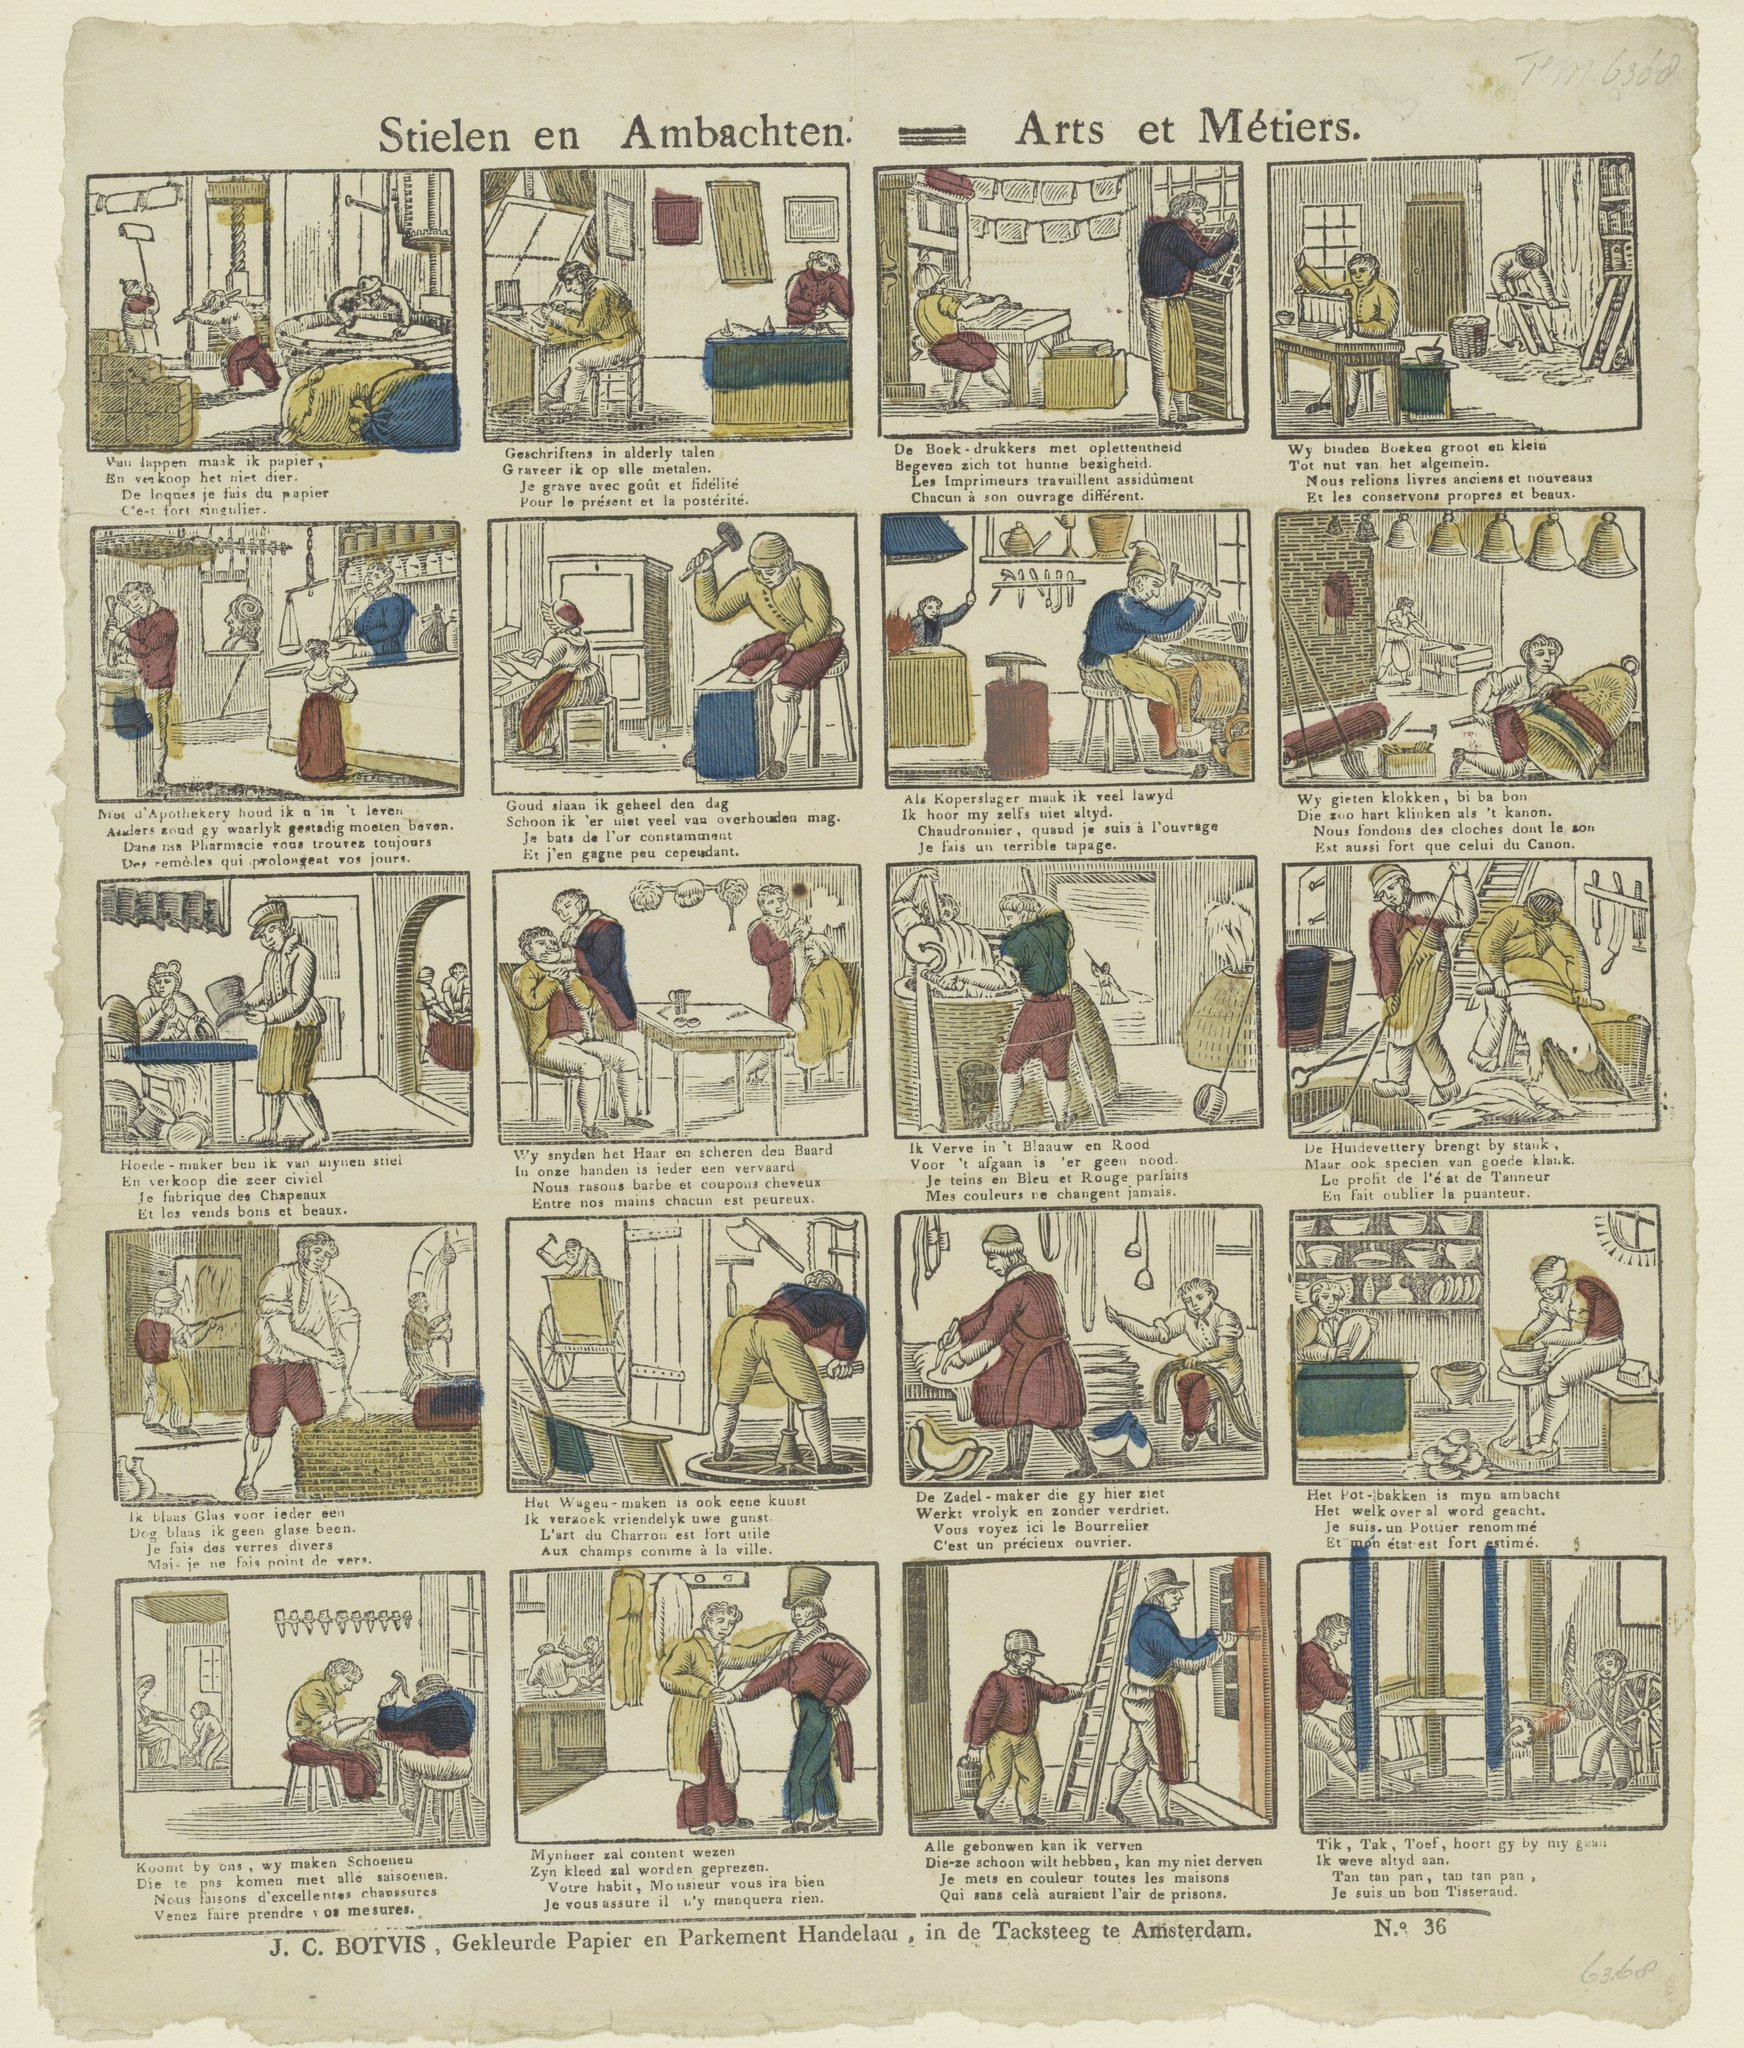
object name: print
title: Stielen en Ambachten / Arts et Métiers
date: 1800-1833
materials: paper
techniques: colour, letterpress printing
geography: turnhout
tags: craft-production, skilled handiwork, pharmacist, druggist, apothecary; pharmacy, drugstore, dispensing chemist, painter at work, in his studio - cc - out of doors, crafts and industries, potter, ceramist, shoe-maker, cobbler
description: Blad met 20 voorstellingen van ambachtslieden en beroepen, zoals papiermaker, koperslager, barbier en schilder. Onder elke afbeelding een tweeregelig vers in het Nederlands of in het Frans. Genummerd rechtsonder: No. 36.